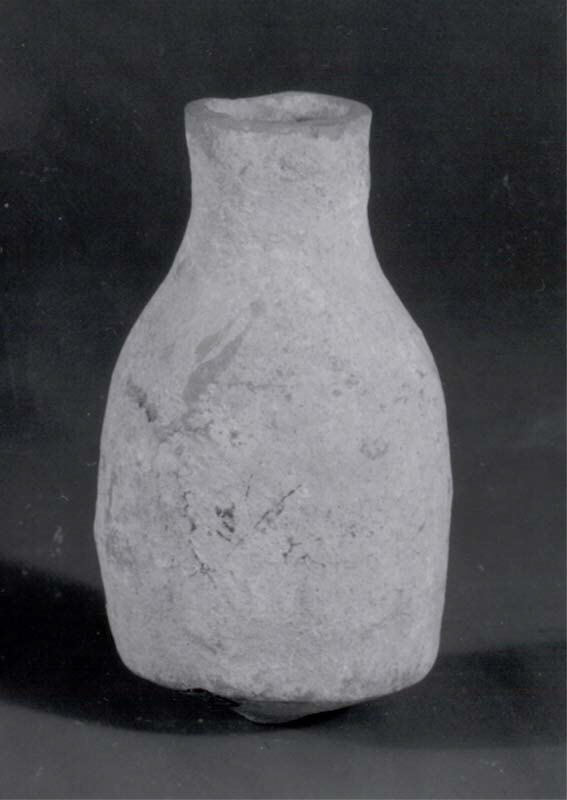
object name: vessel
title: Unguentarium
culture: nabataean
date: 1-100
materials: ceramic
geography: levant